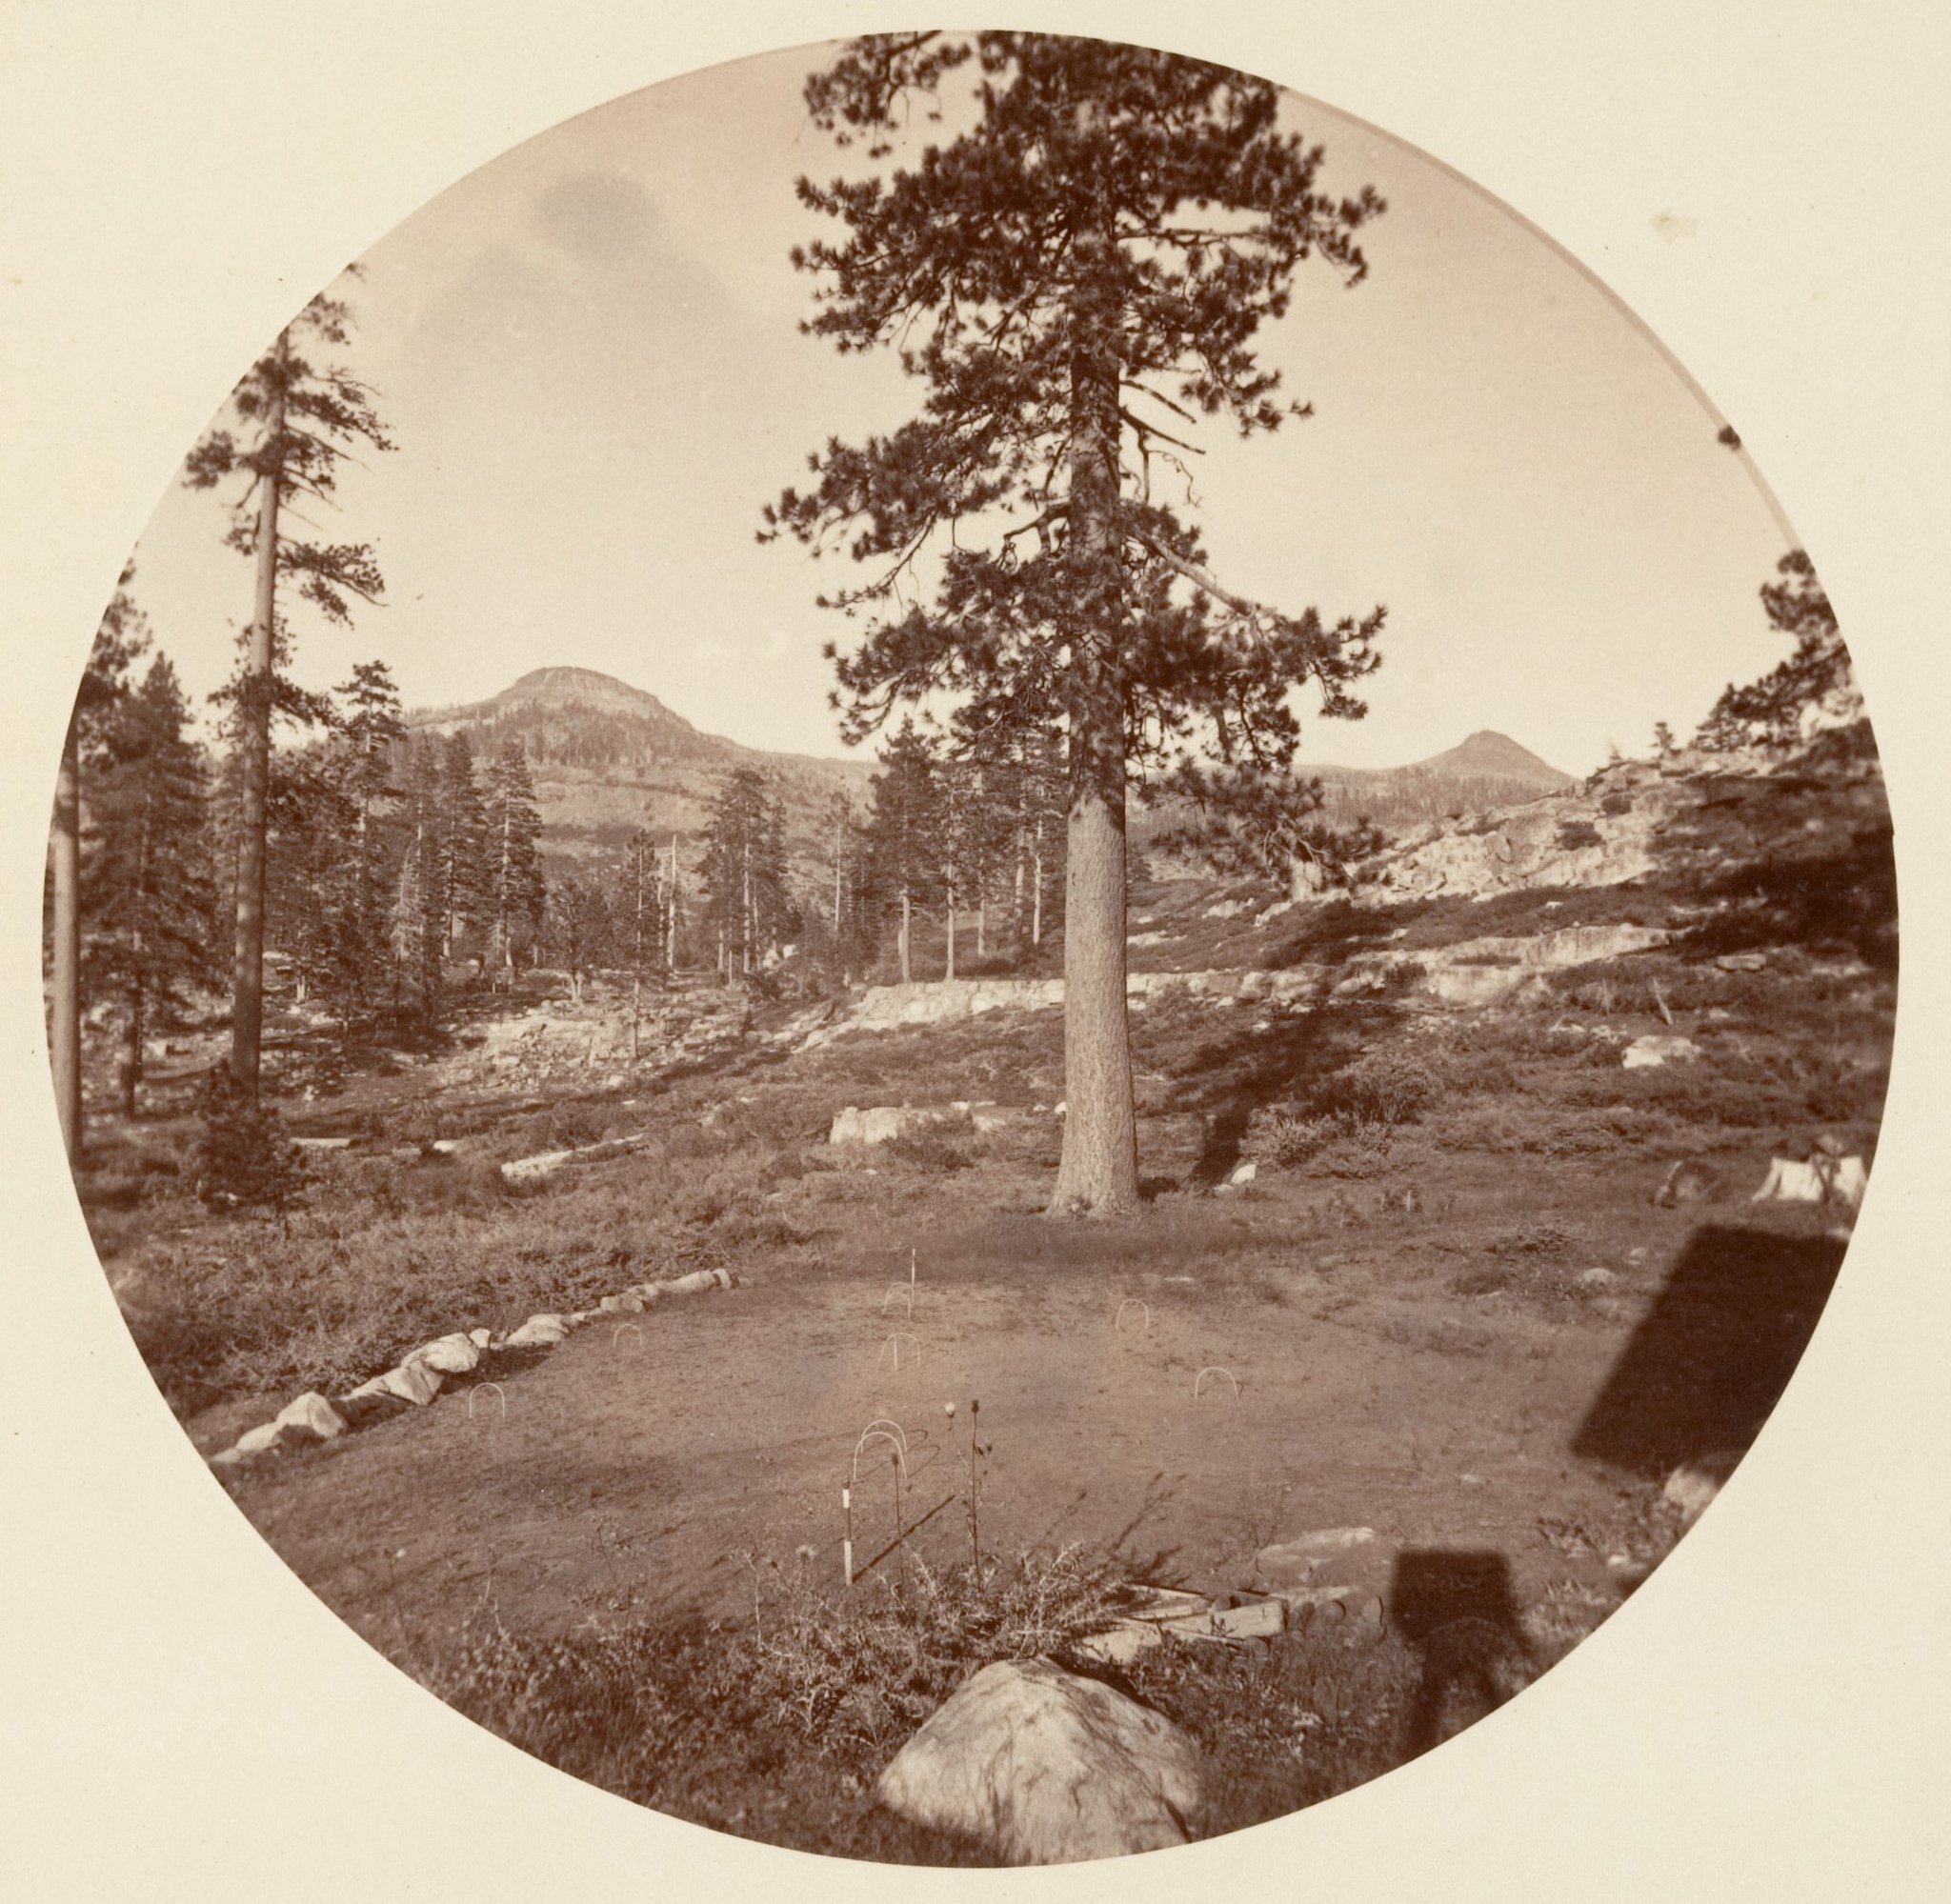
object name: photograph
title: [Yosemite National Park, California]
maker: carleton e. watkins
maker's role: artist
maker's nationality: american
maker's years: 1829-1916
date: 1878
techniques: albumen silver print, glass negative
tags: mountains,landscapes